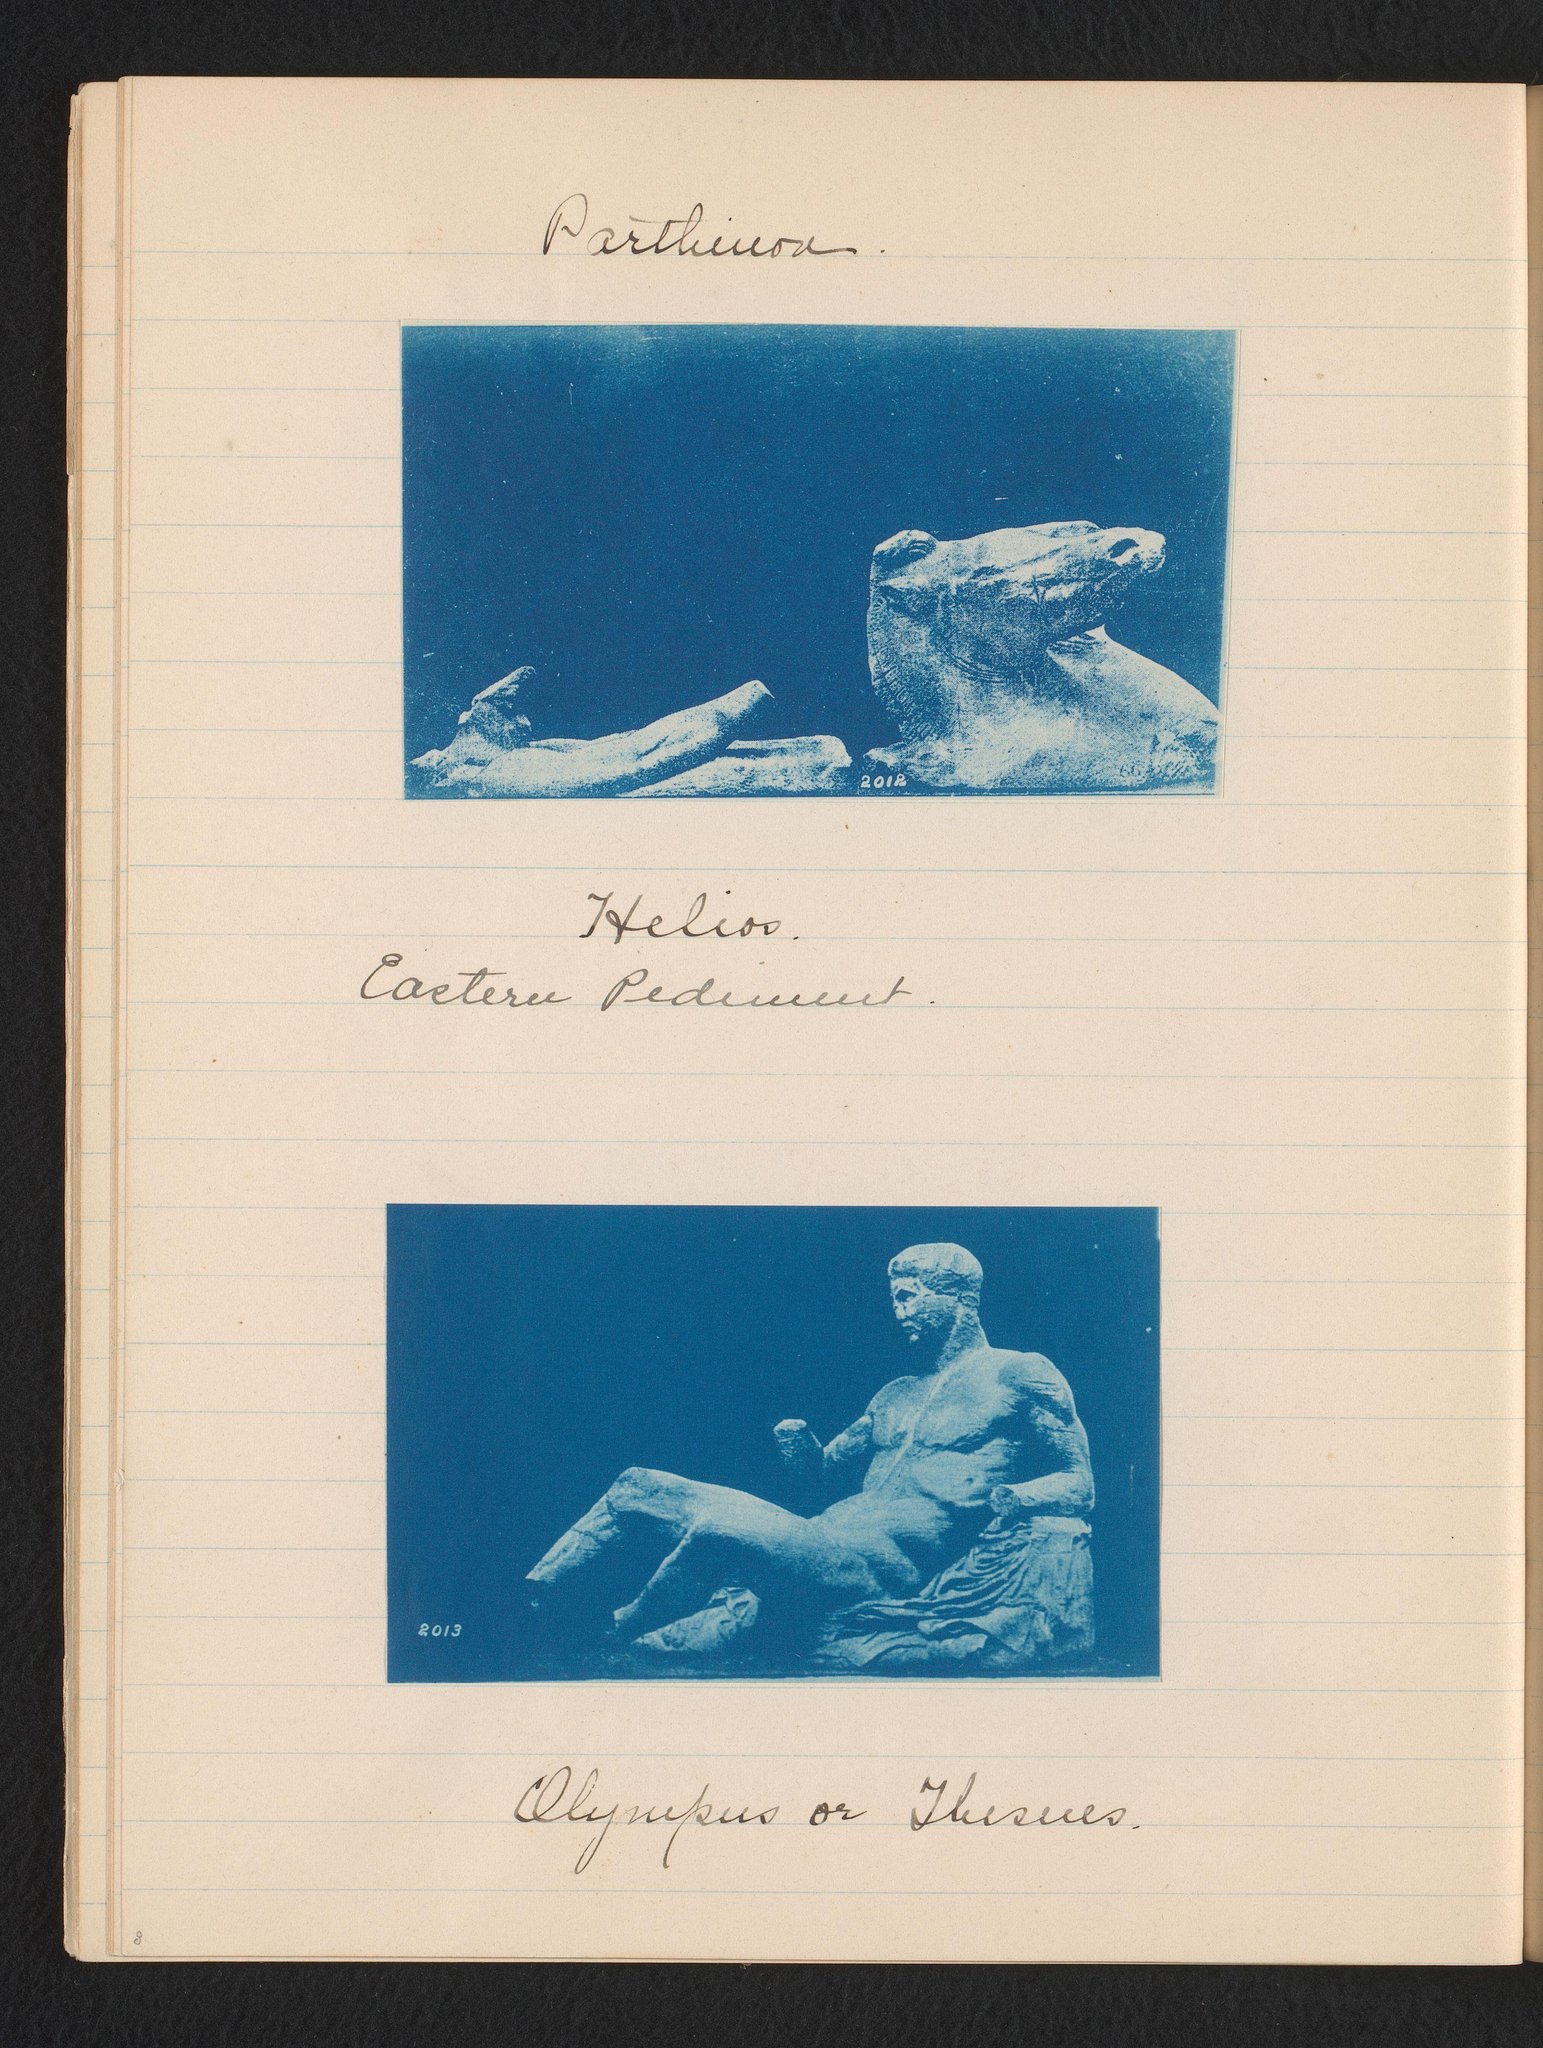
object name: photograph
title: Parthenon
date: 1901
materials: paper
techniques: cyanotype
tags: piece of sculpture, reproduction of a piece of sculpture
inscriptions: inscription: ‘Helios/ Eastern Pediment/ Olympus or Theseus’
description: Deze foto's maken deel uit van een album.